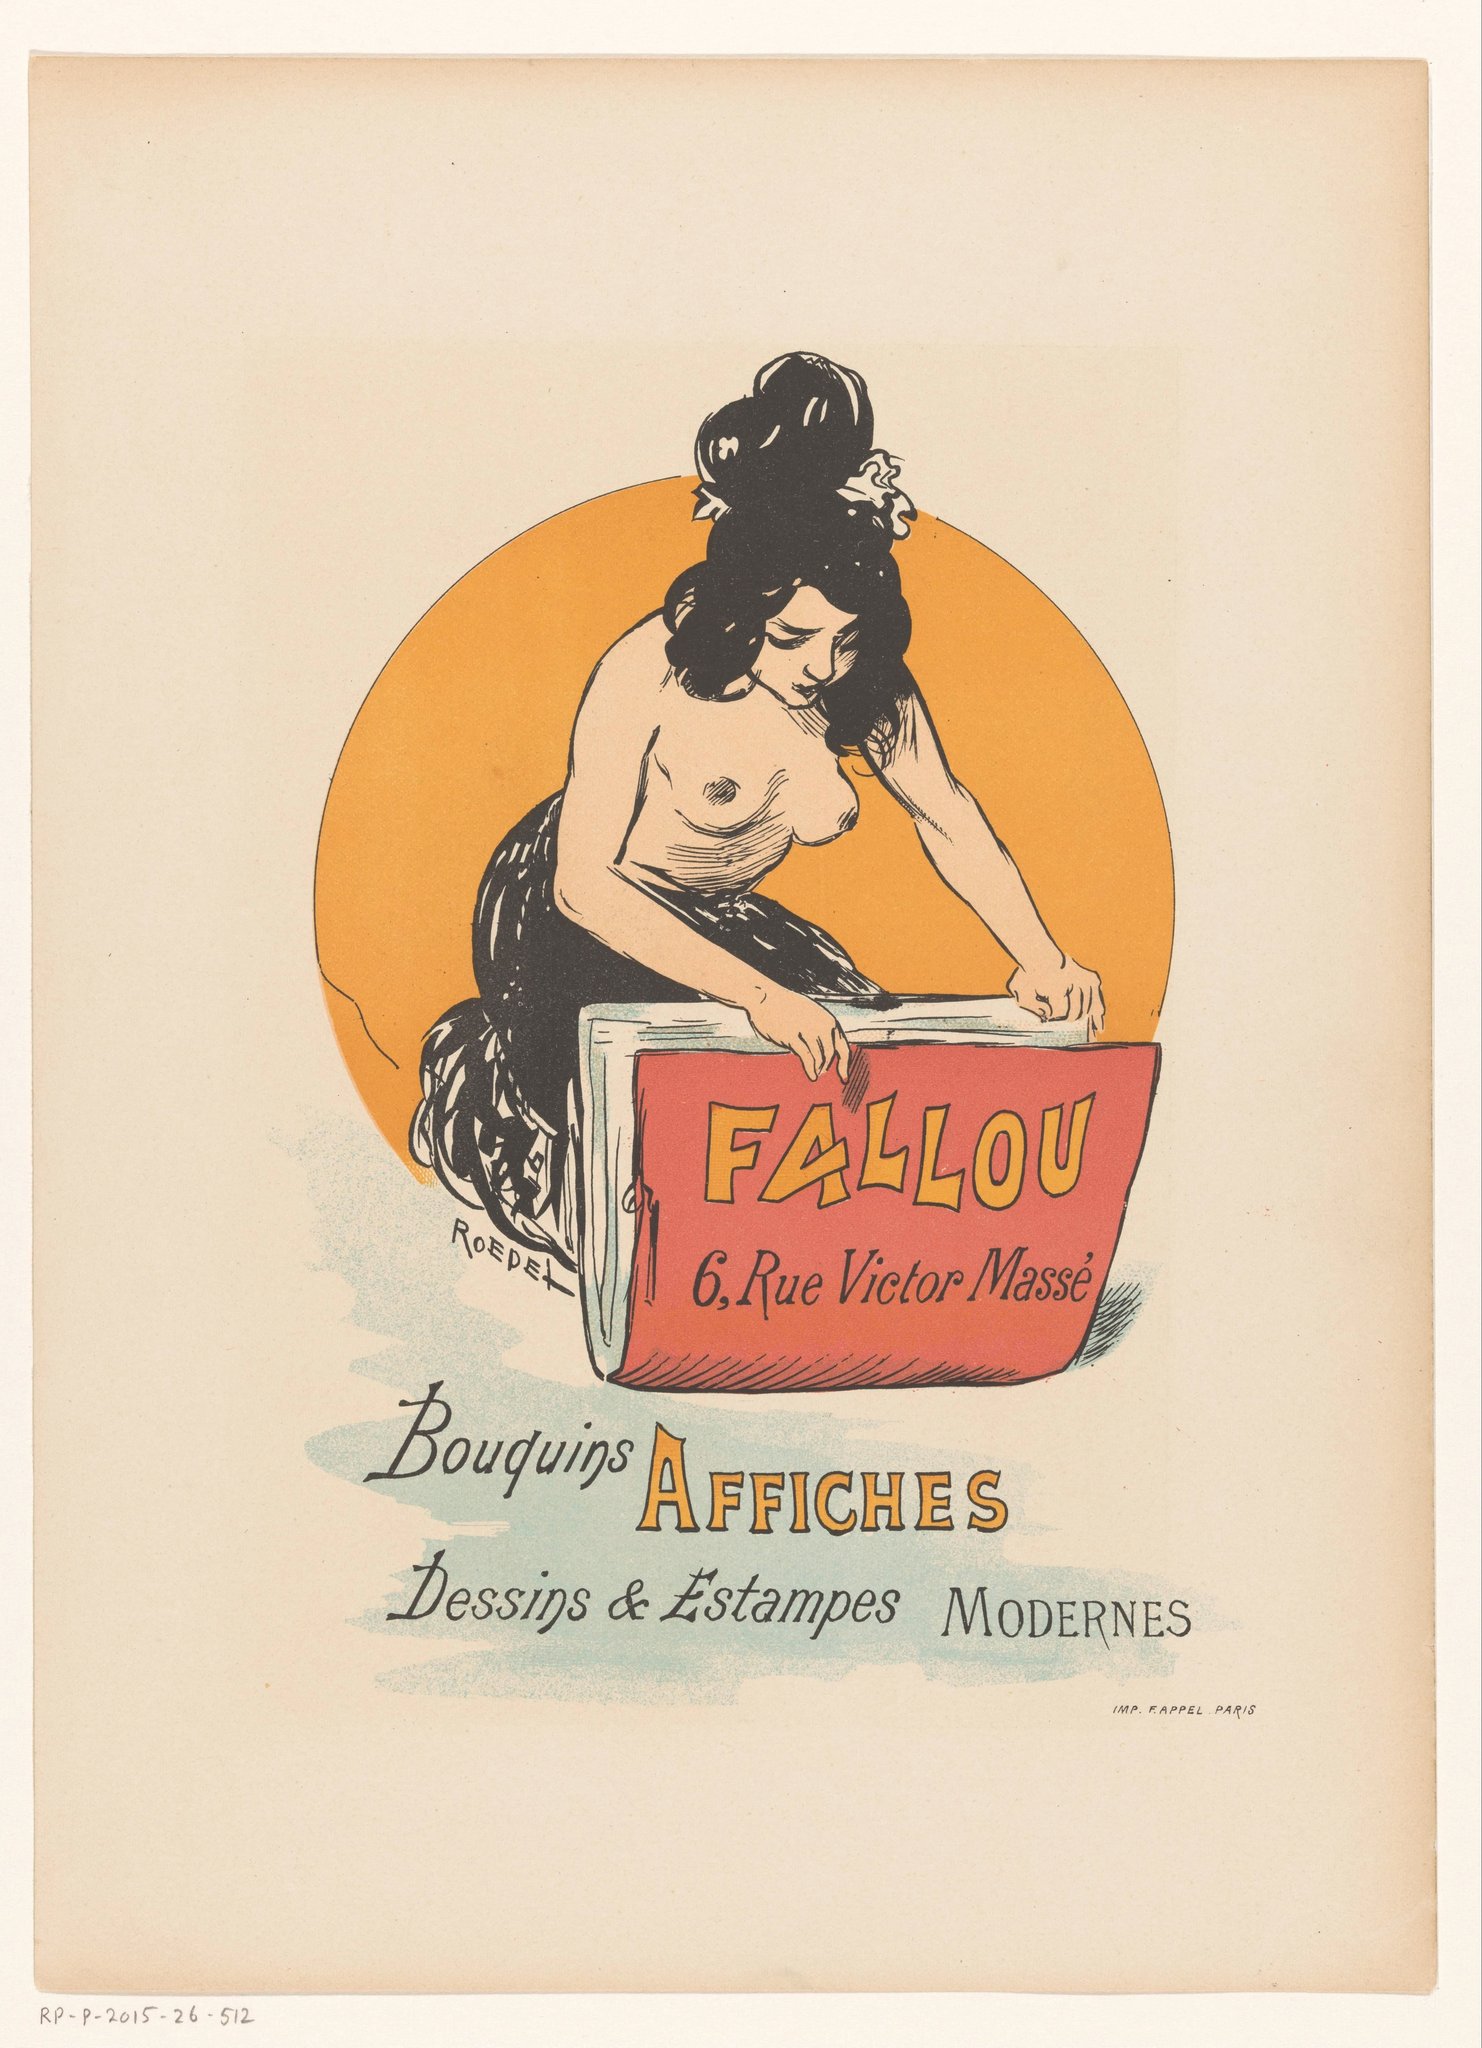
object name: poster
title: Affiche voor boek- en prenthandel Fallou te Parijs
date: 1869-1900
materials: paper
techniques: lithograph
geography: paris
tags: woman (showing herself) undressed, quasi-nude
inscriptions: collector's mark: Lugt 2228, collector's mark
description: Een geknielde vrouw met ontbloot bovenlijf en bloemen in haar haar opent een map met prenten.